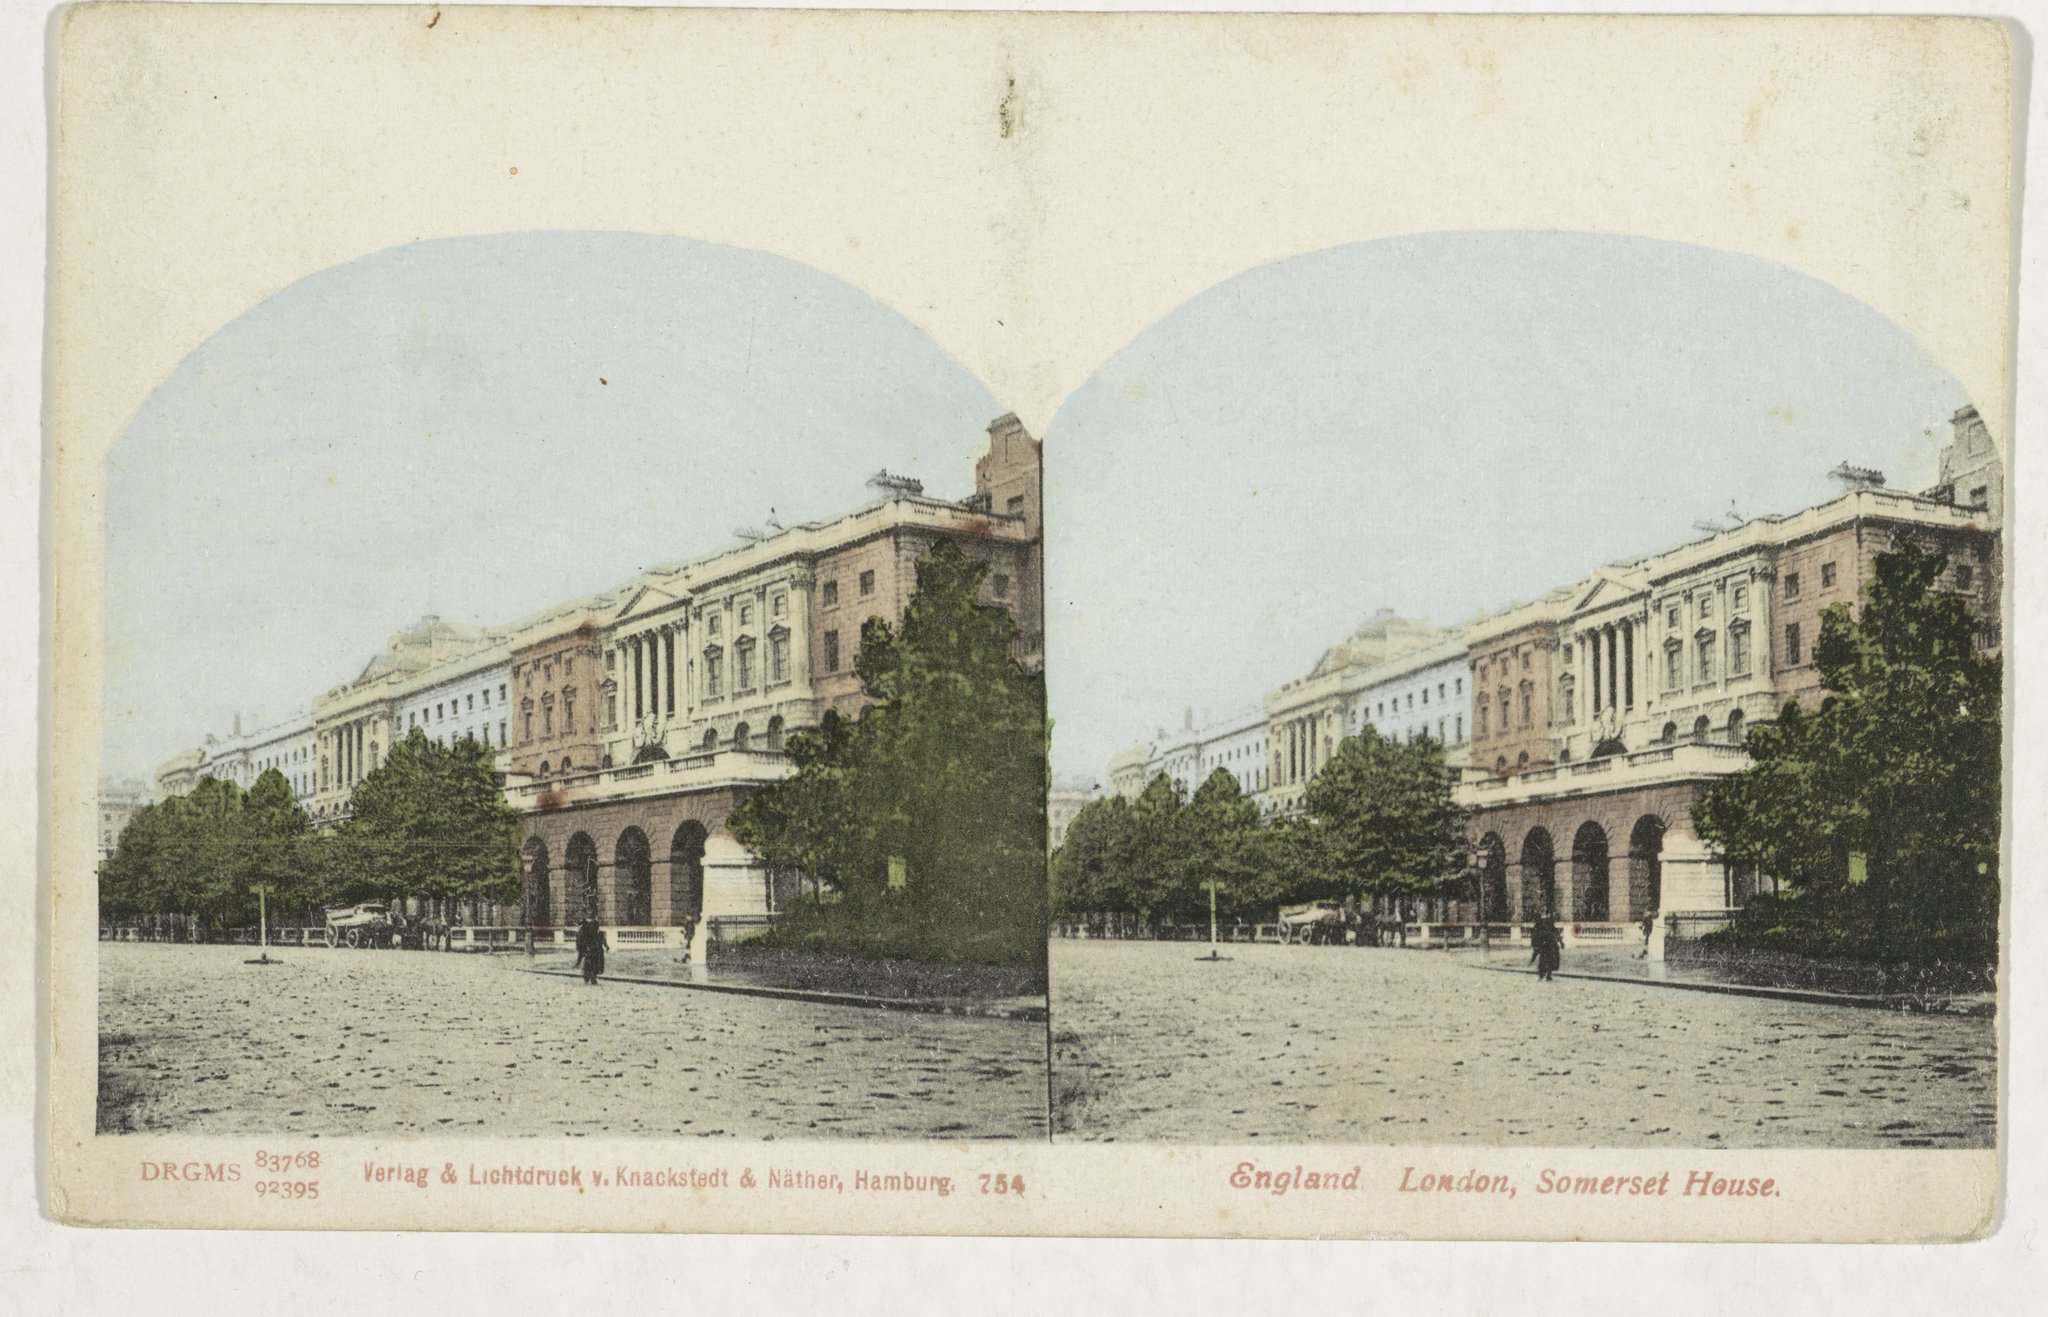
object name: stereograph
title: Harz-Ansichten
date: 1868-1890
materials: cardboard, paper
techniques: albumen print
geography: berlin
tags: dining-room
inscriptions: number: ‘2b’, inscription: ‘145/ 96’, inscription: ‘Photograph in Magdeburg.’